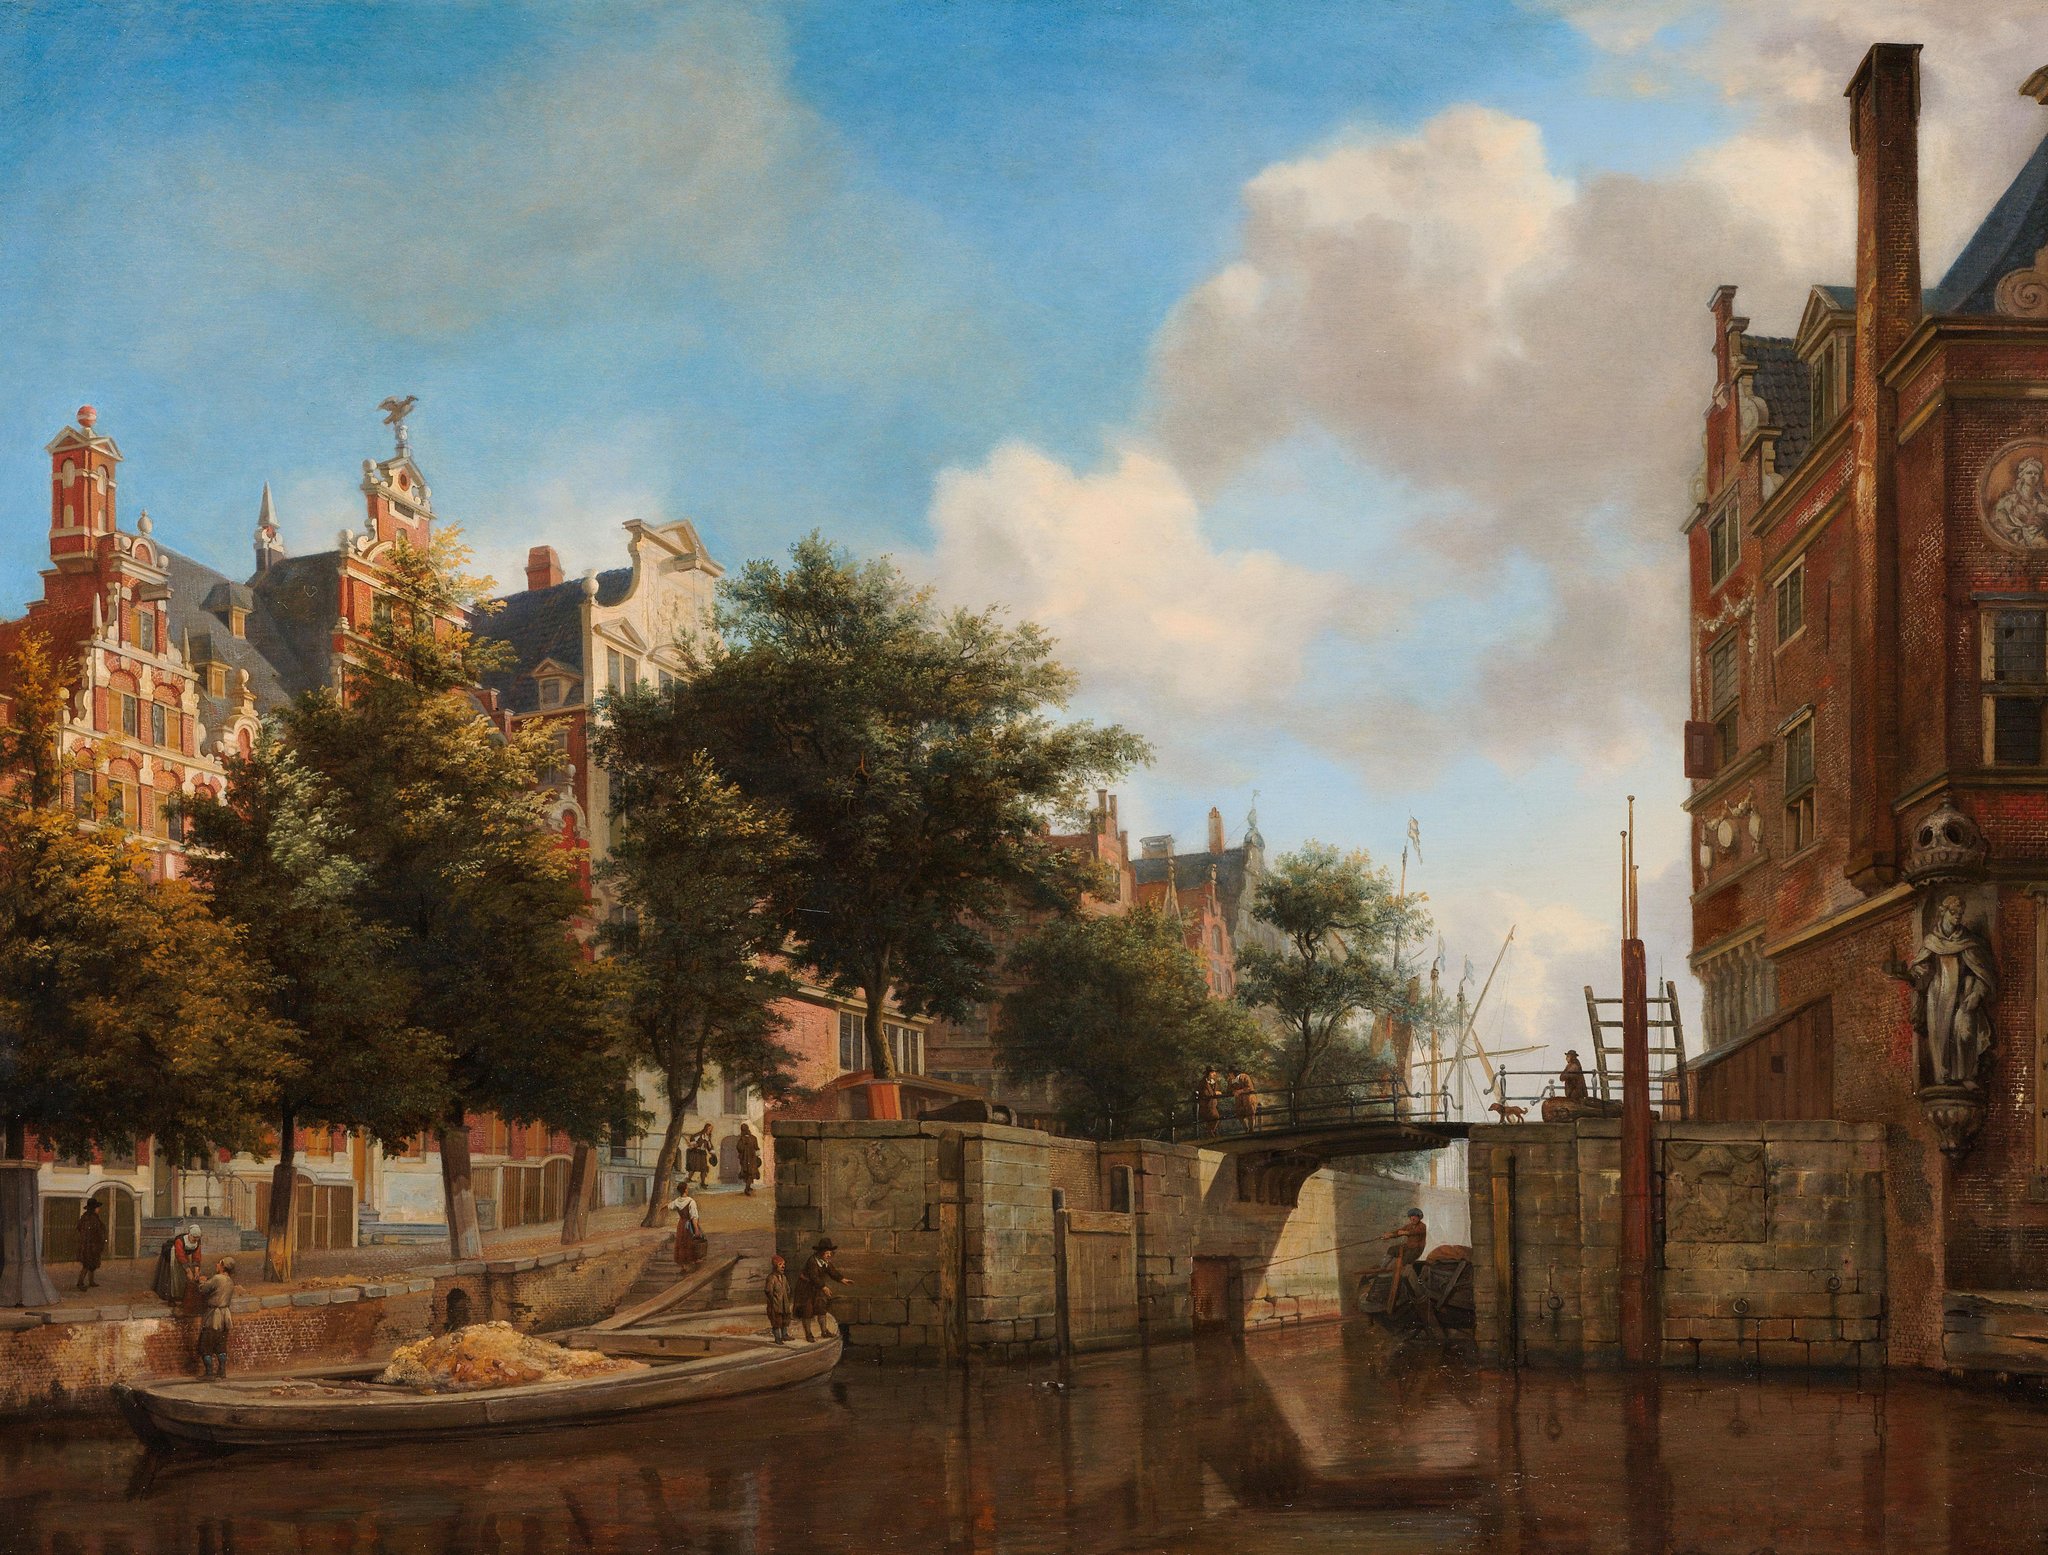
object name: painting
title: Amsterdam City View with Houses on the Herengracht and the old Haarlemmersluis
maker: jan van der heyden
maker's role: draughtsman, painter, print maker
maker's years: 1637-1712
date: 1670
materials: oil, panel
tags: canals, waters (in city), bridge in city across river, canal, etc.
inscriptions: signature: ‘VDHeyde’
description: Van der Heyden captured the activity on and around the water in Amsterdam’s old town centre. With an eye for detail, he painted the old Haarlemmersluis, a lock on the Nieuwezijds Voorburgwal. However, the picture does not present a real location: Van der Heyden combined the lock with a row of houses that is actually on a different canal, the Herengracht.